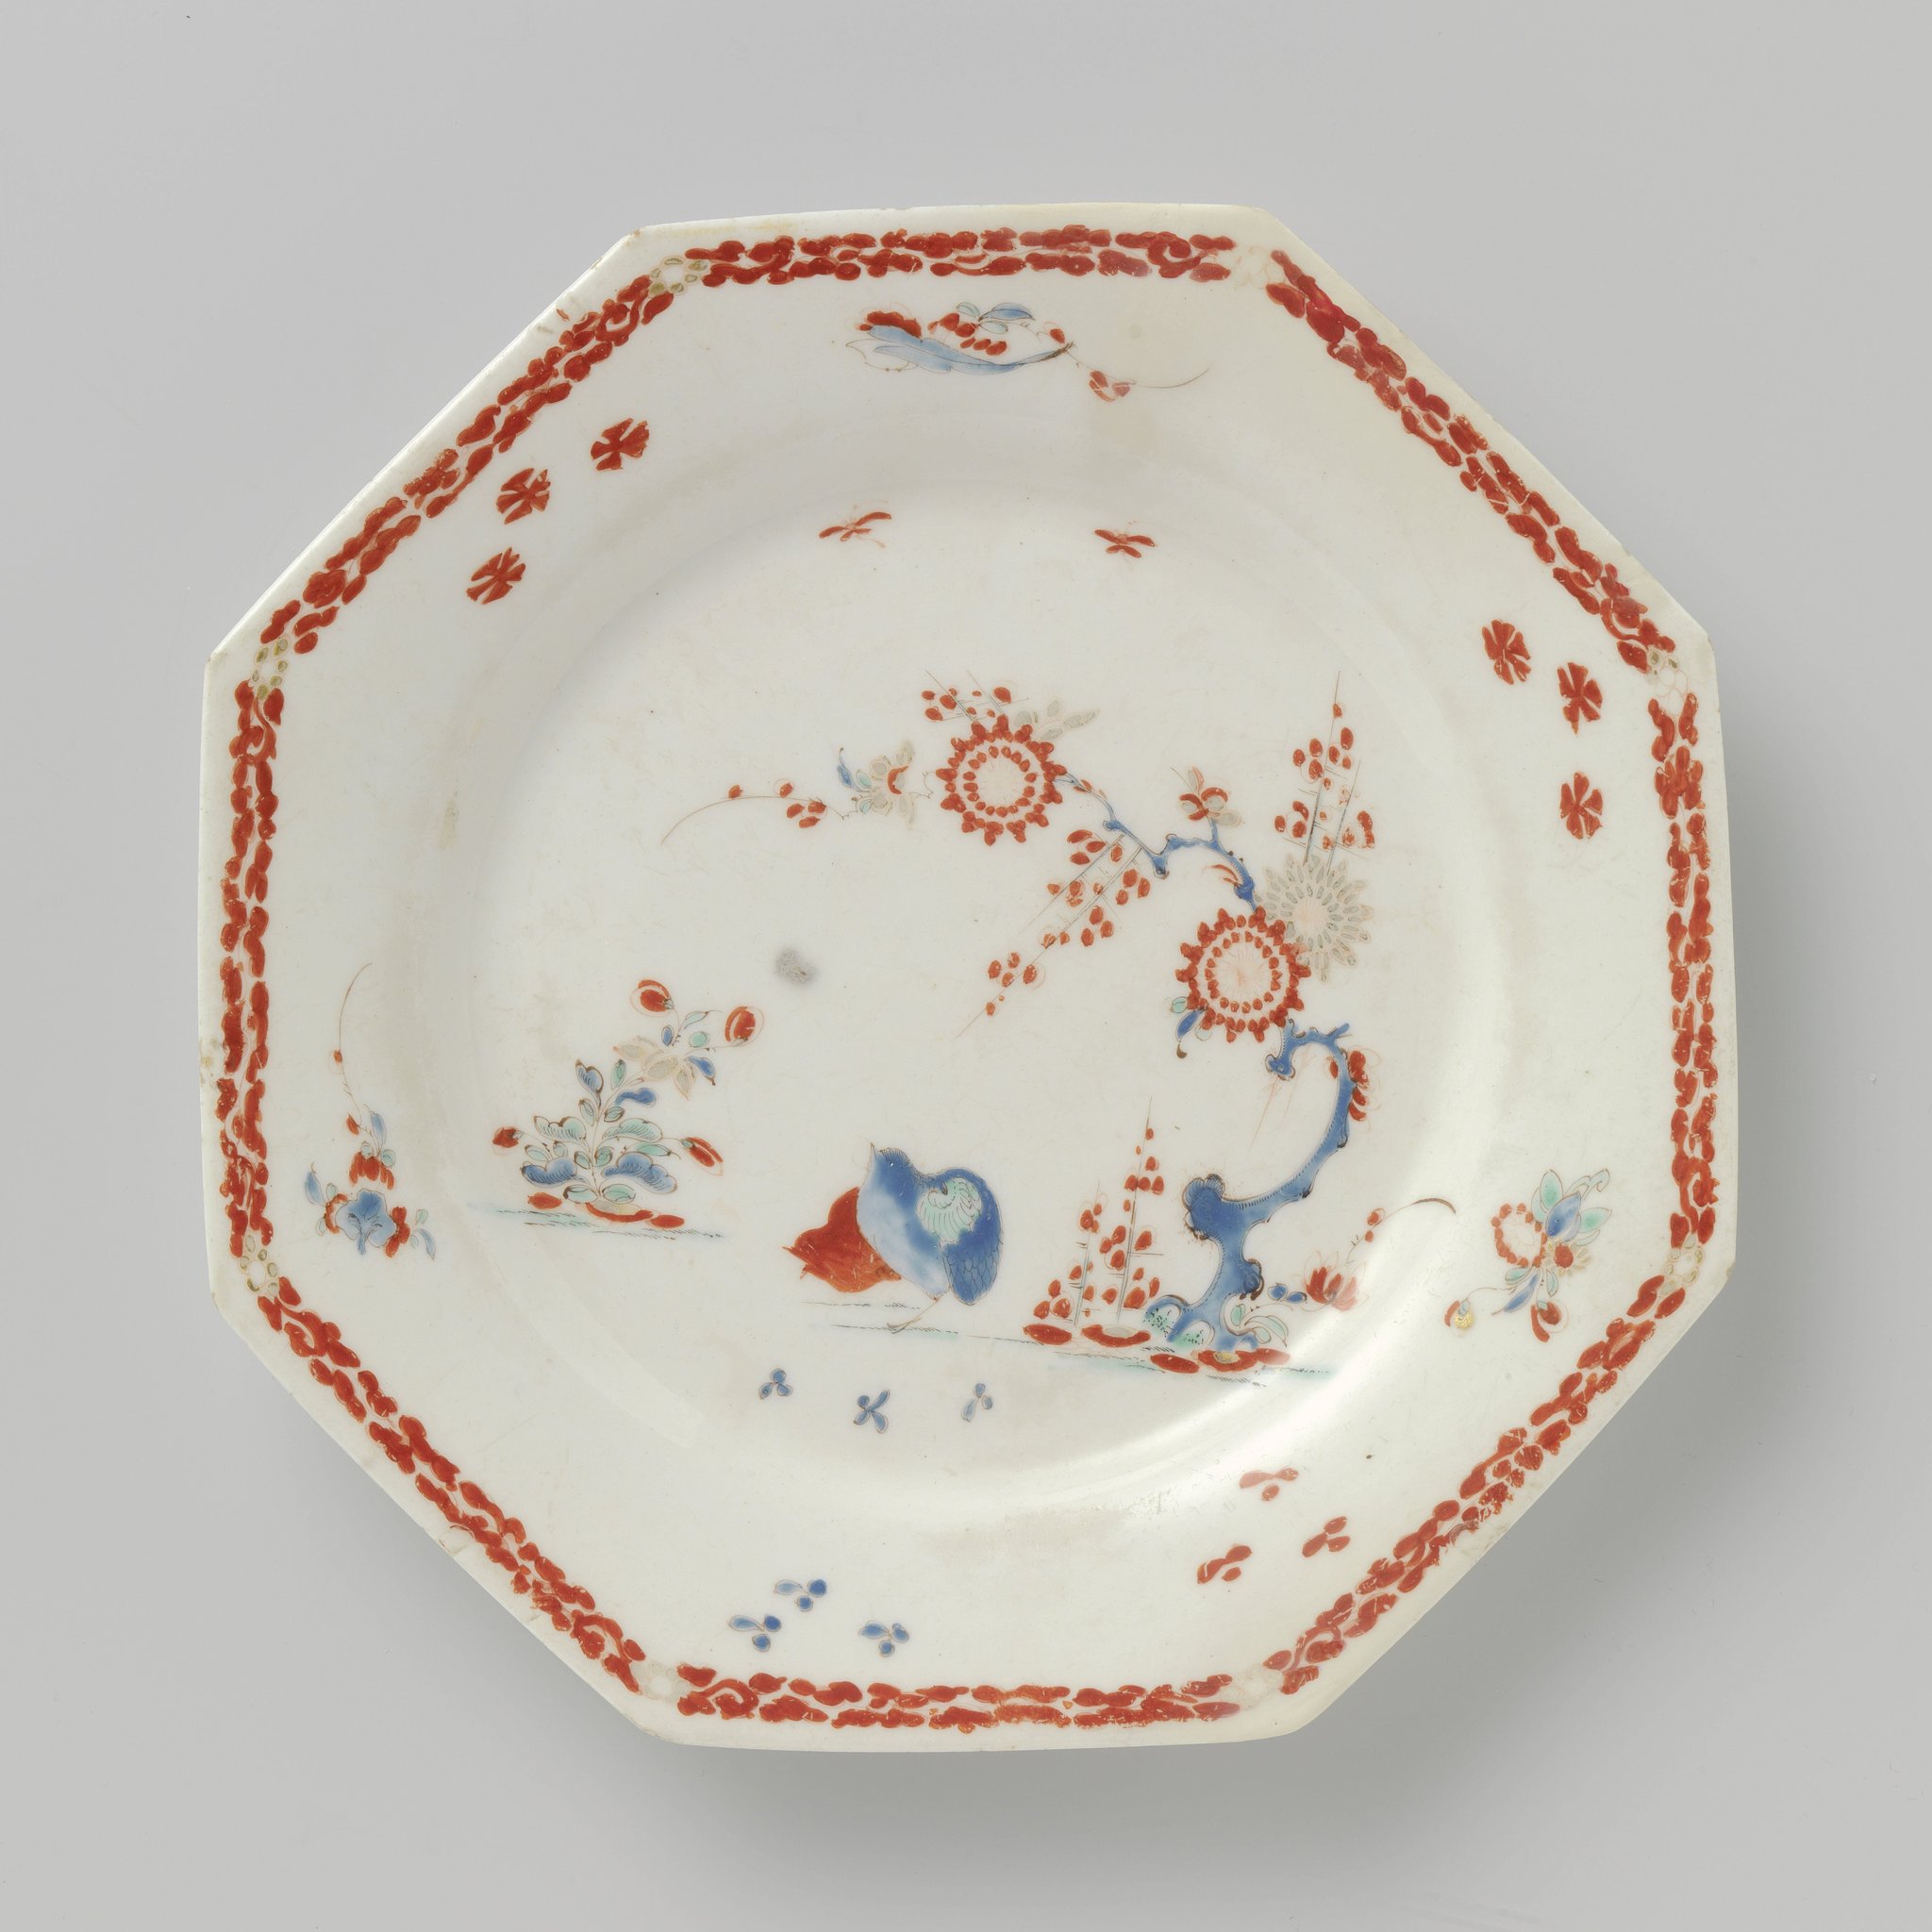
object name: plate dish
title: Bord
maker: Anonymous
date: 1750-1775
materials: glaze, gold, porcelain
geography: bow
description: Achthoekig bord. Gedecoreerd in emails en enig goud op het glazuur. In navolging van een japans voorbeeld. In het plat twee kwartels bij bloeiende planten; op de rand bloemtakken, omgeven door en band met gestileerde bladranken.